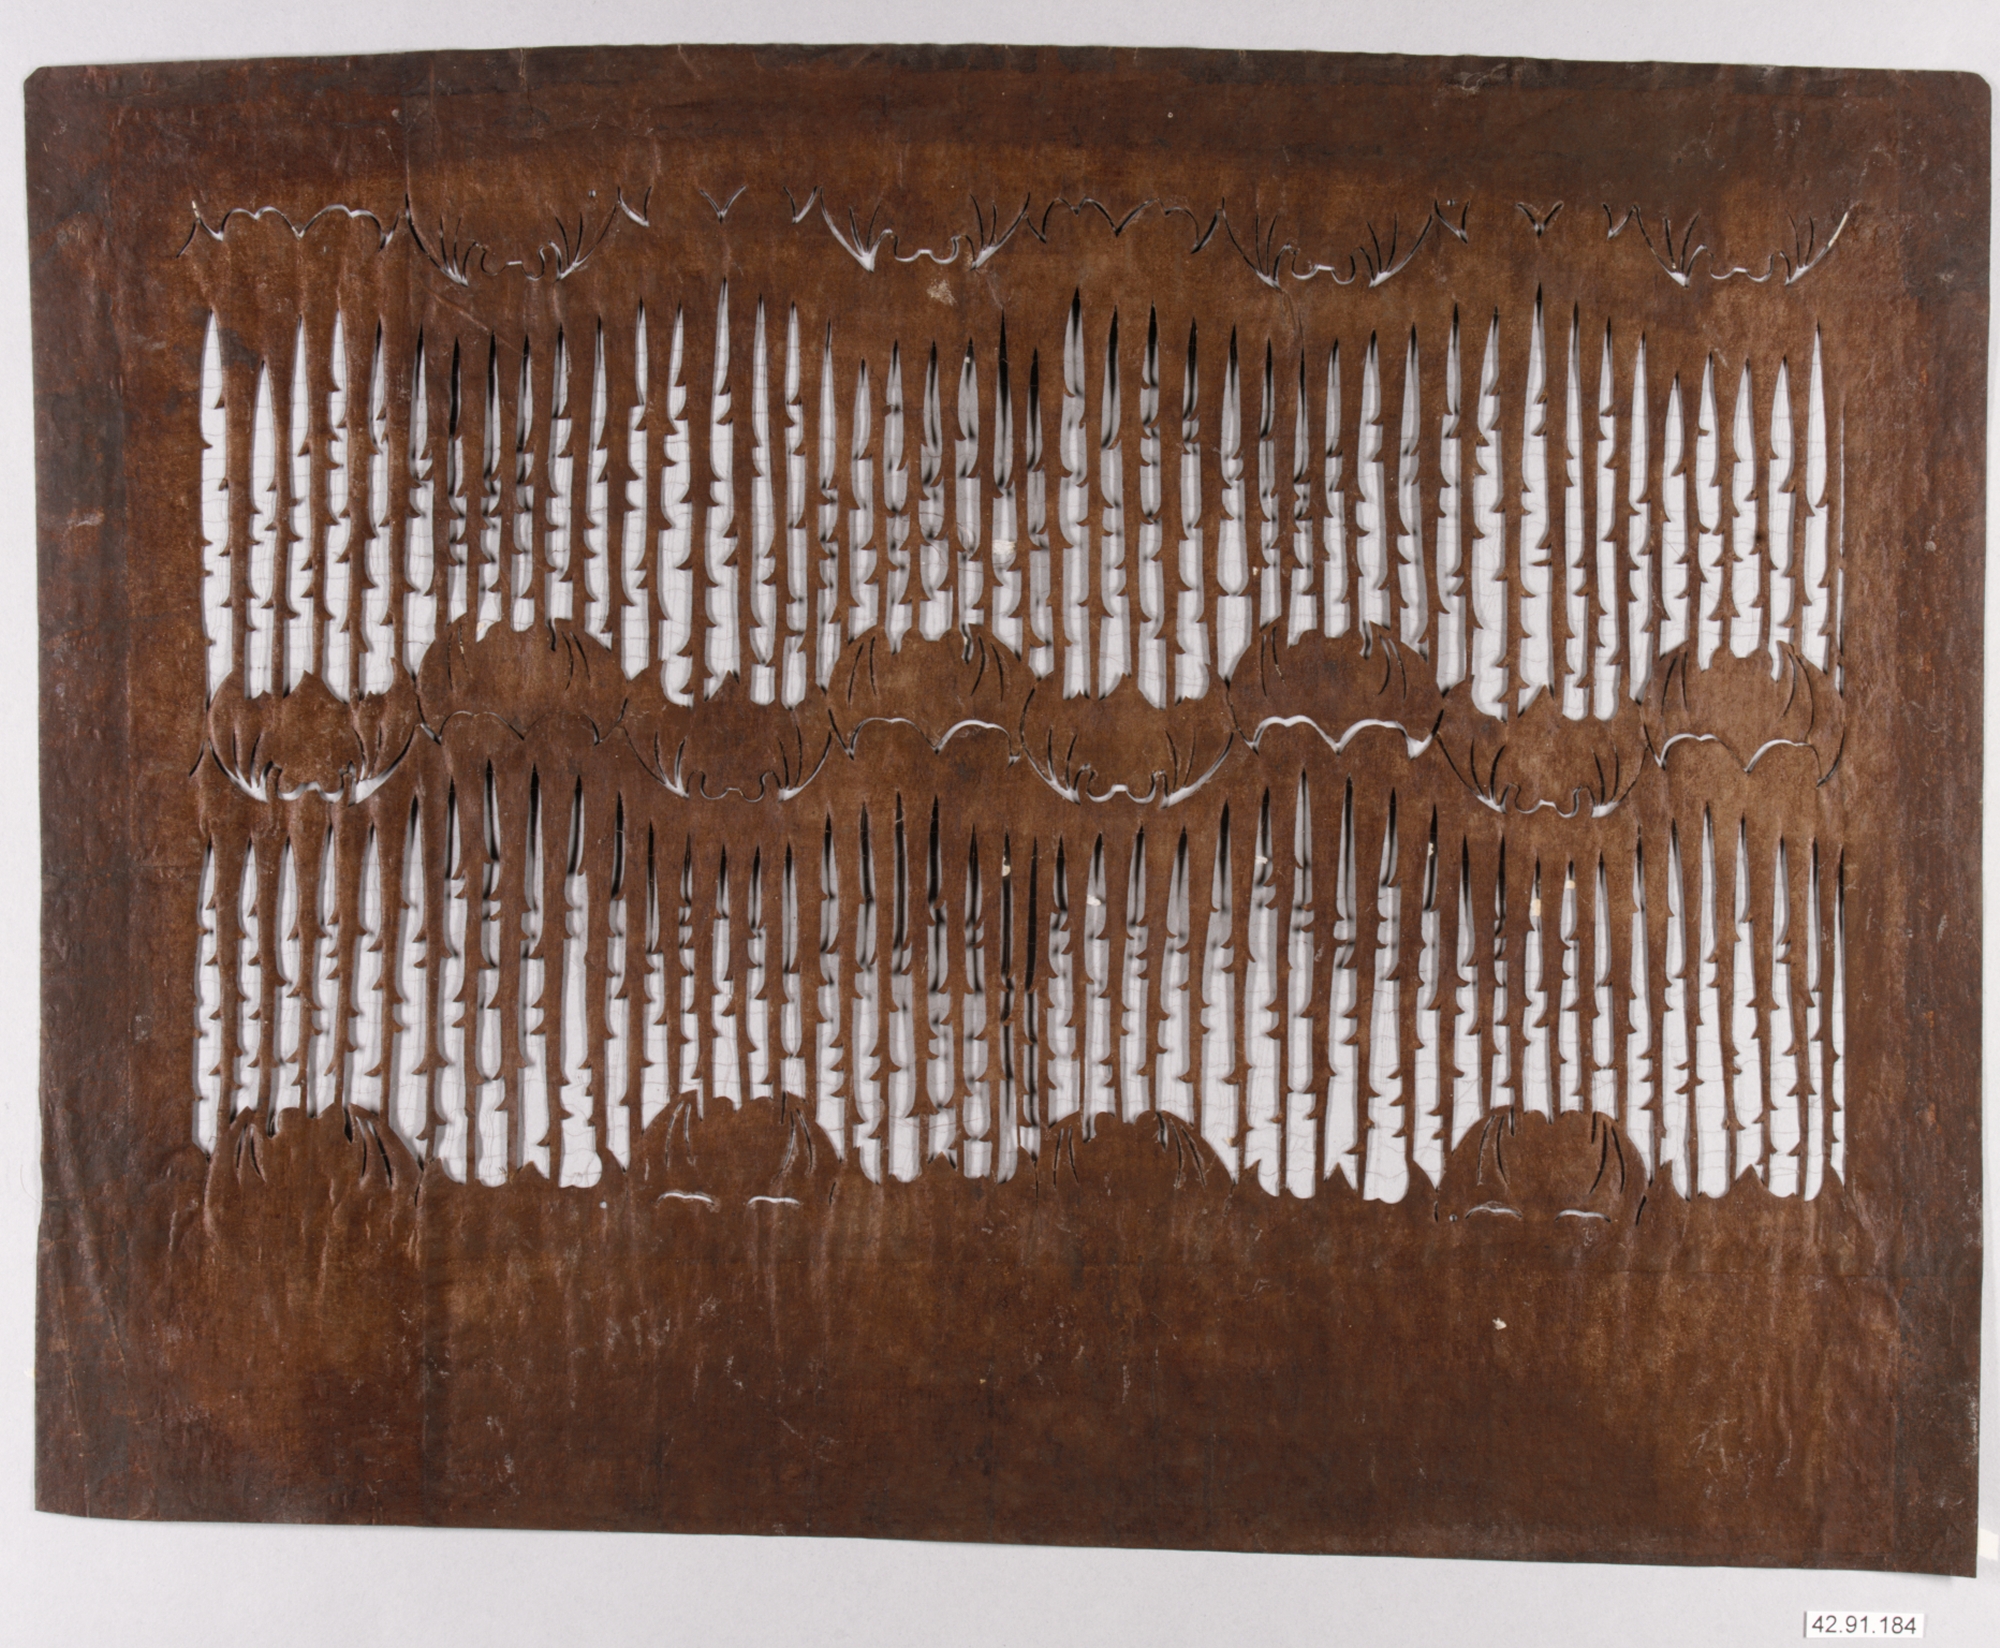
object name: stencil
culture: japanese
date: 1801-1900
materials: paper, silk